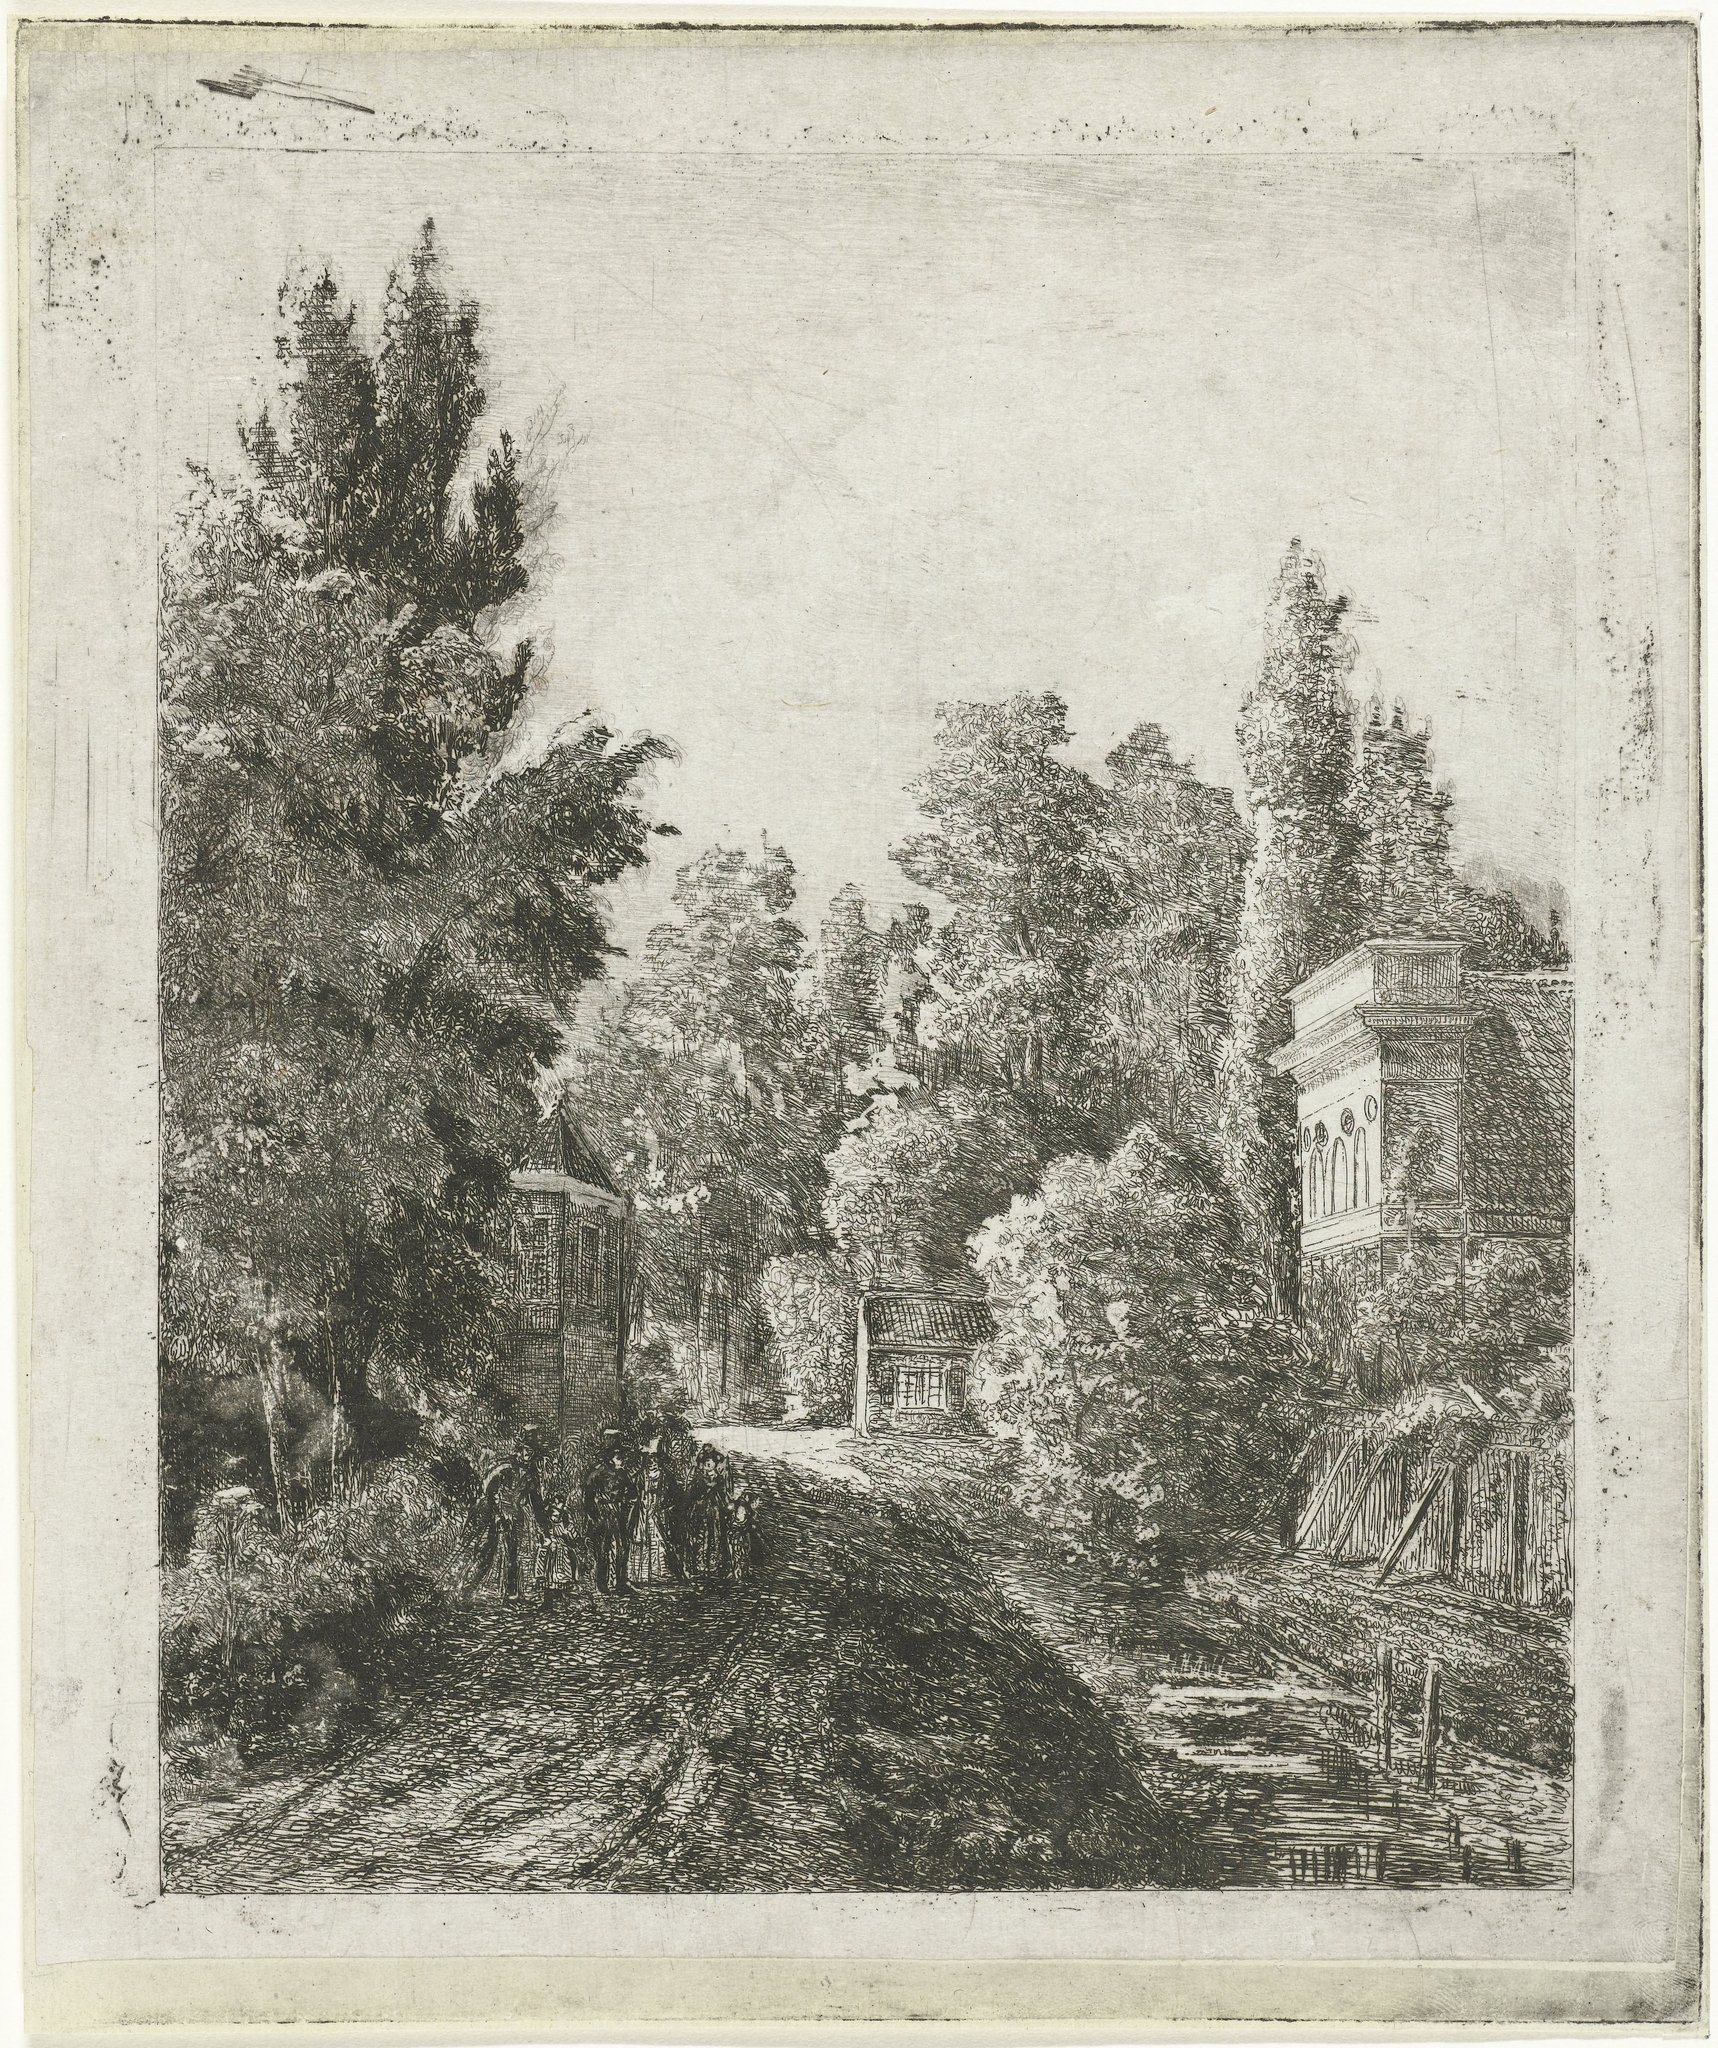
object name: print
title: Dorpsstraat met een wandelend gezelschap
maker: johannes adrianus van der drift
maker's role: print maker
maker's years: 1808-1883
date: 1823-1883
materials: paper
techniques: etching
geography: netherlands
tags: village lane, alley (+ city(-scape) with figures, staffage)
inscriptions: collector's mark: Lugt 2228